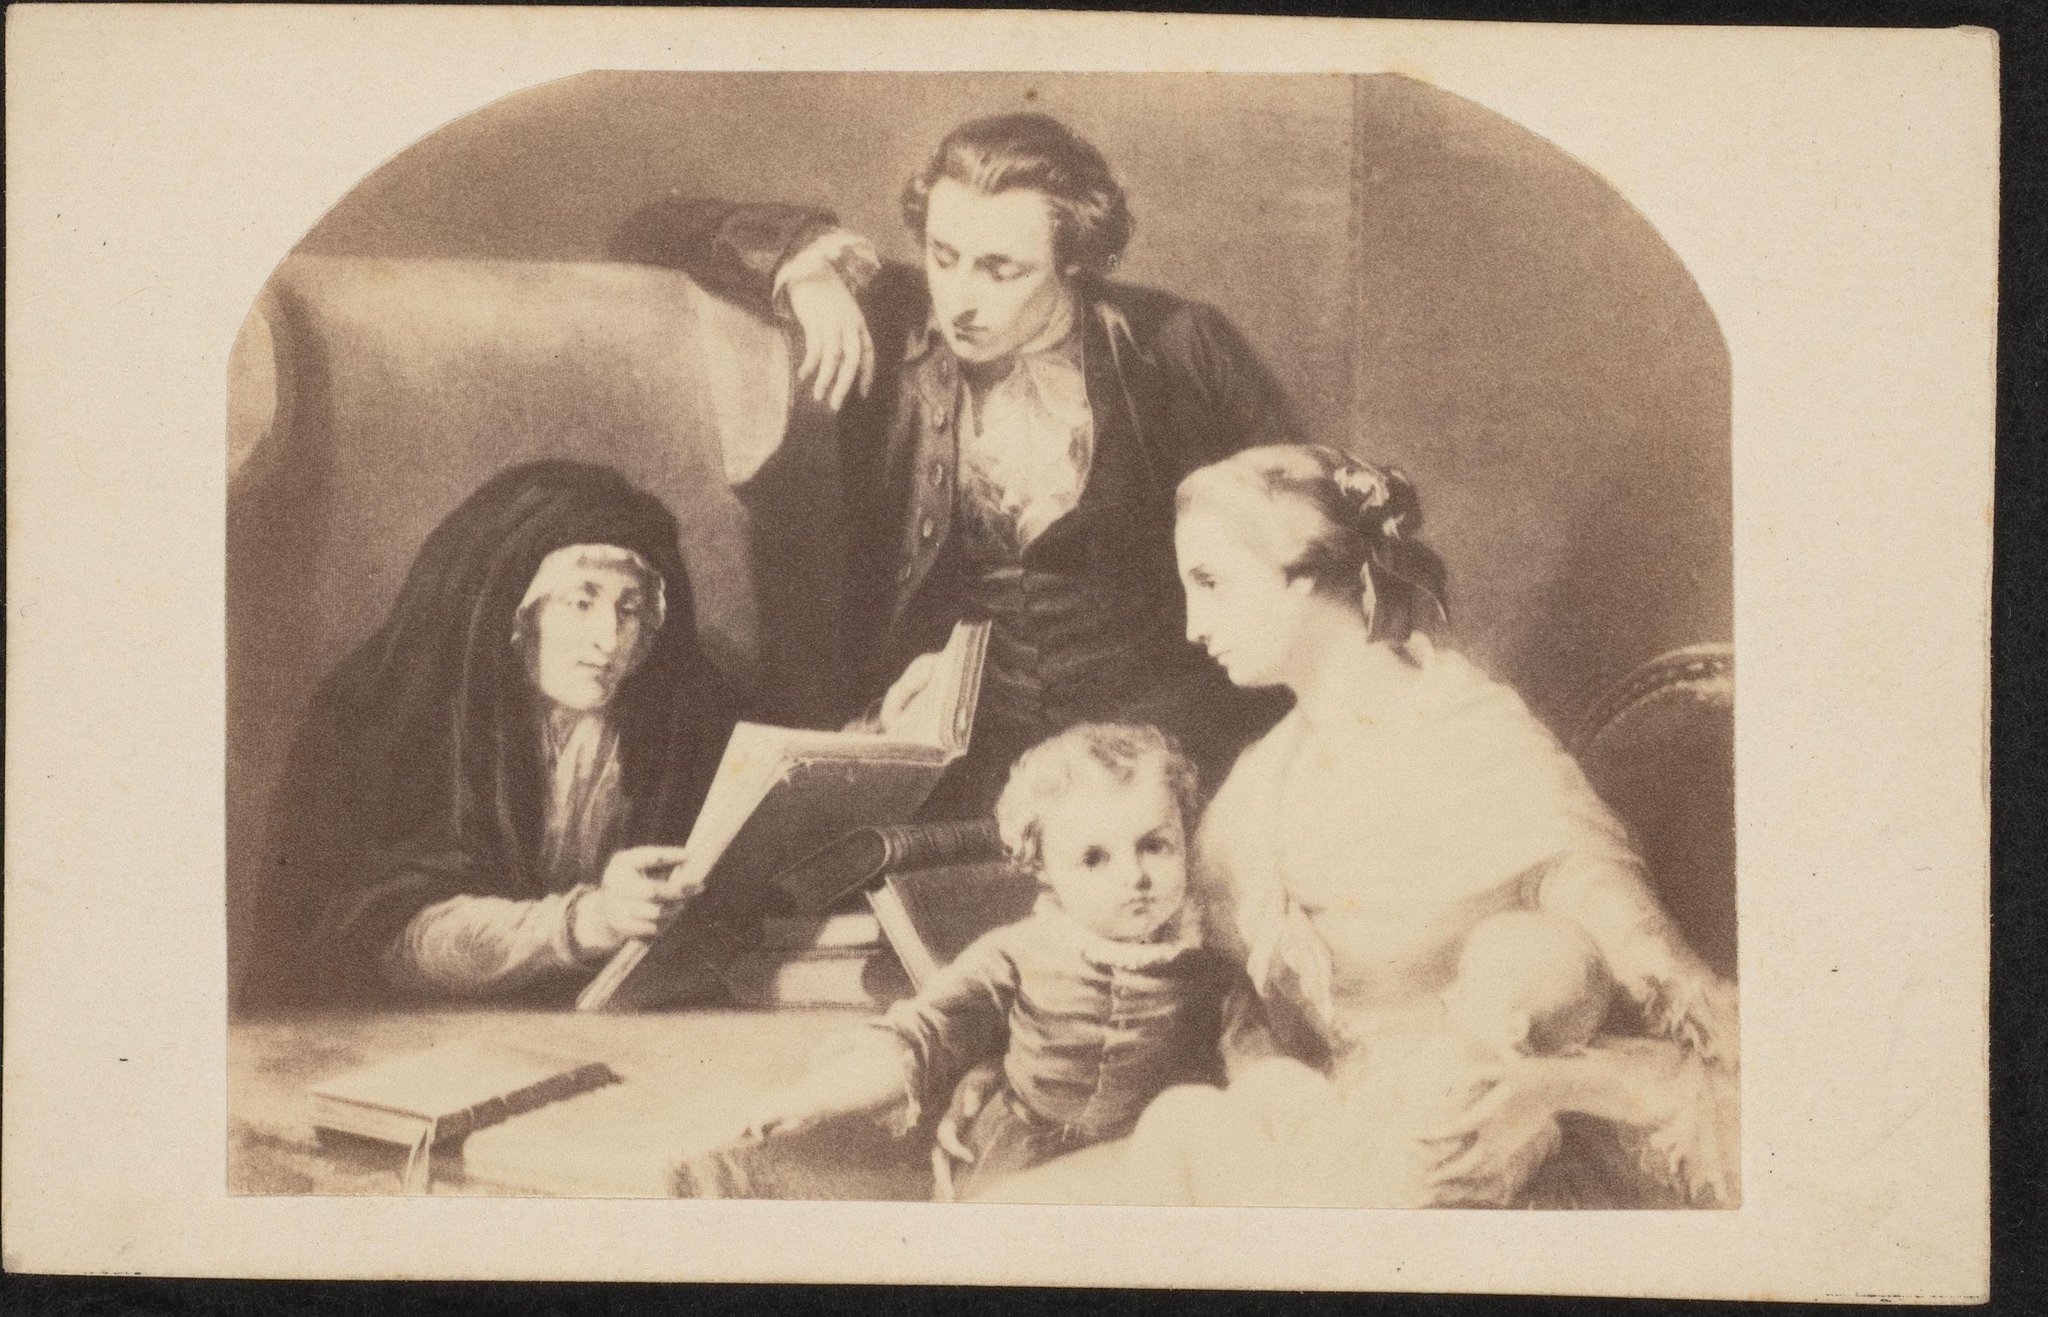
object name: carte de visite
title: Fotoreproductie van schilderij, gezin rondom oude vrouw met boeken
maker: Anonymous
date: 1860-1900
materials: cardboard, photographic support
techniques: albumen print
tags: old woman, family life